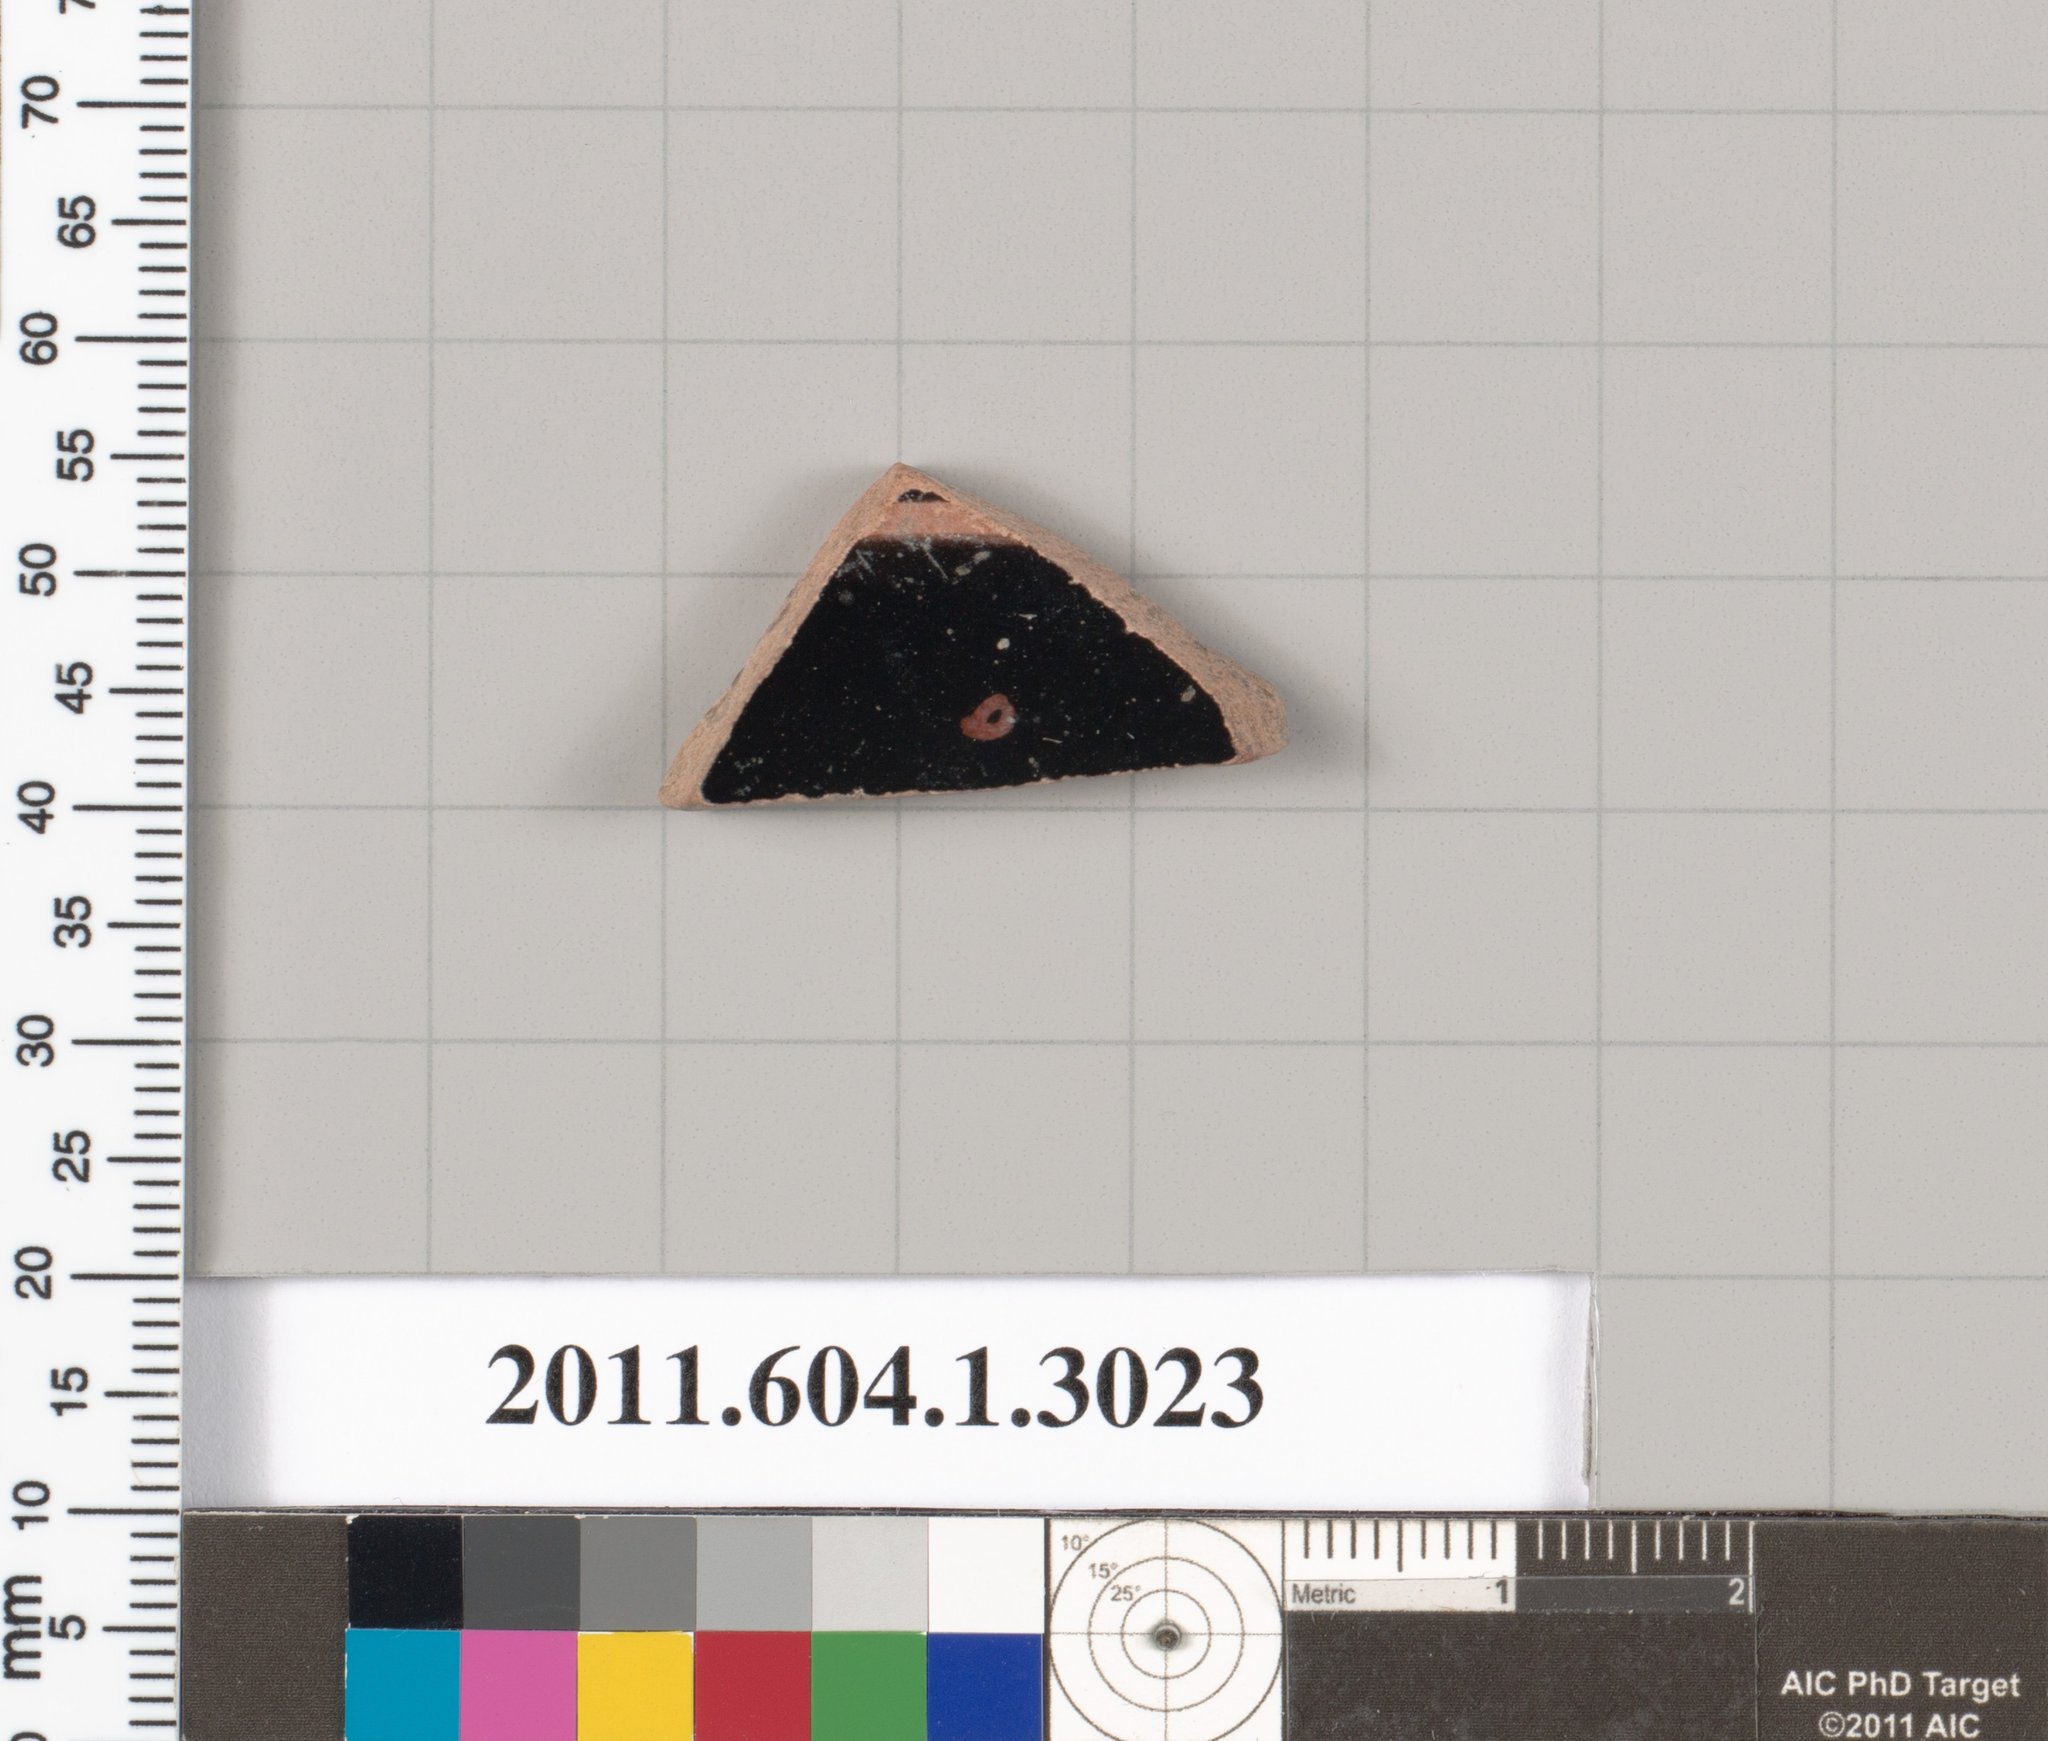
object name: kylix fragment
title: Terracotta fragment of a kylix (drinking cup)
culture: greek, attic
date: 510-490 BCE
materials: terracotta